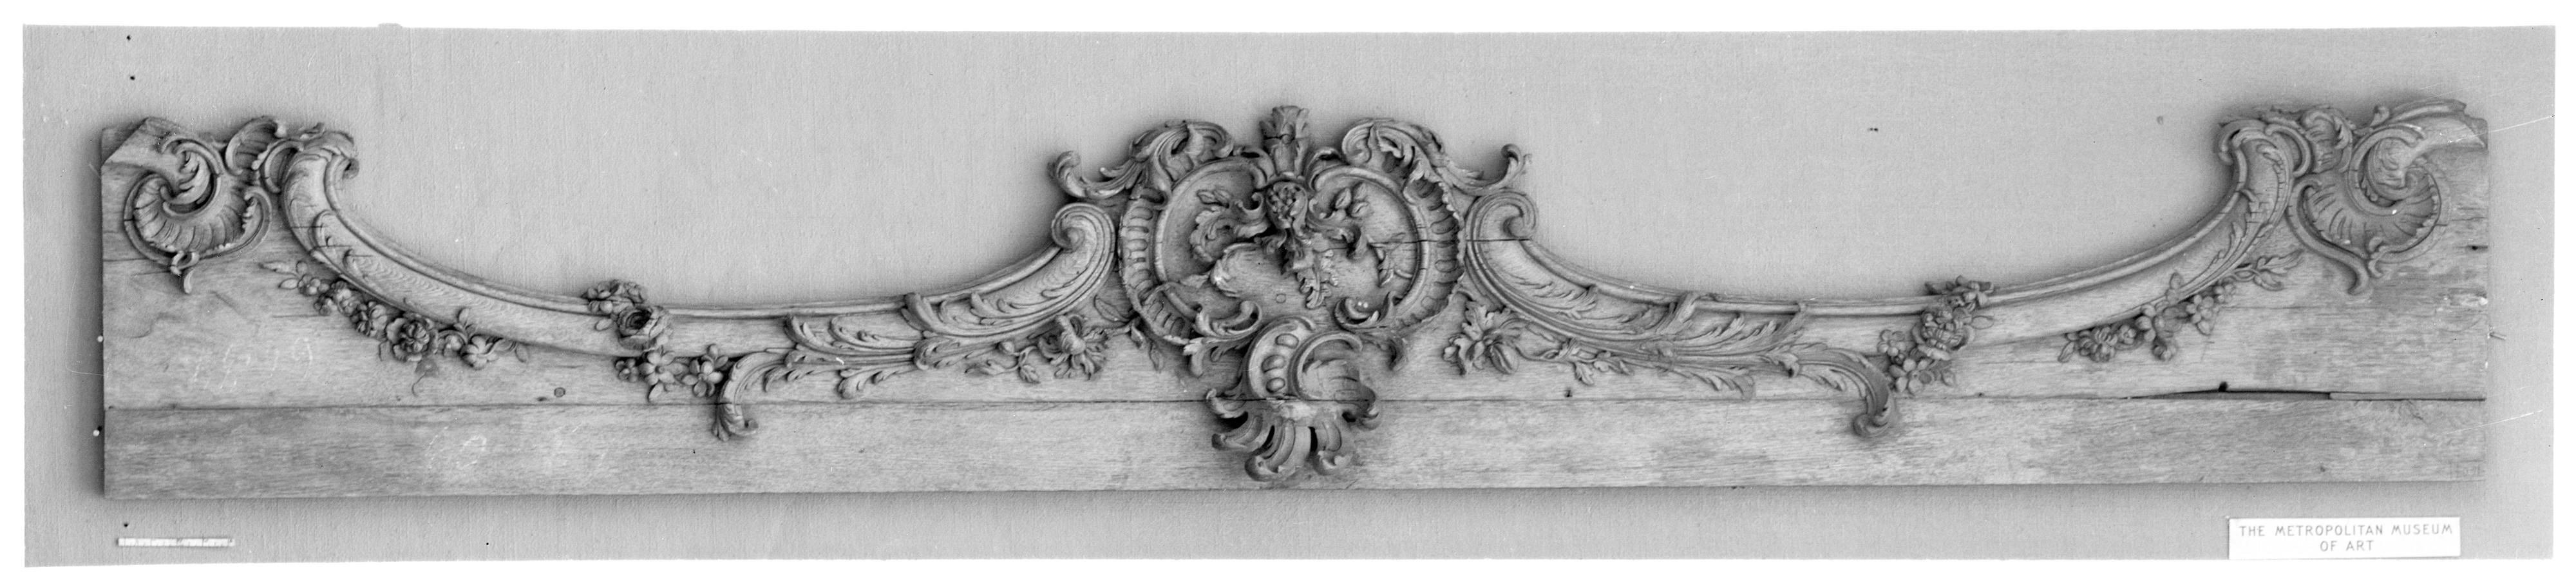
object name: panel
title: Panel (Dessus d'alcove)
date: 1701-1750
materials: wood